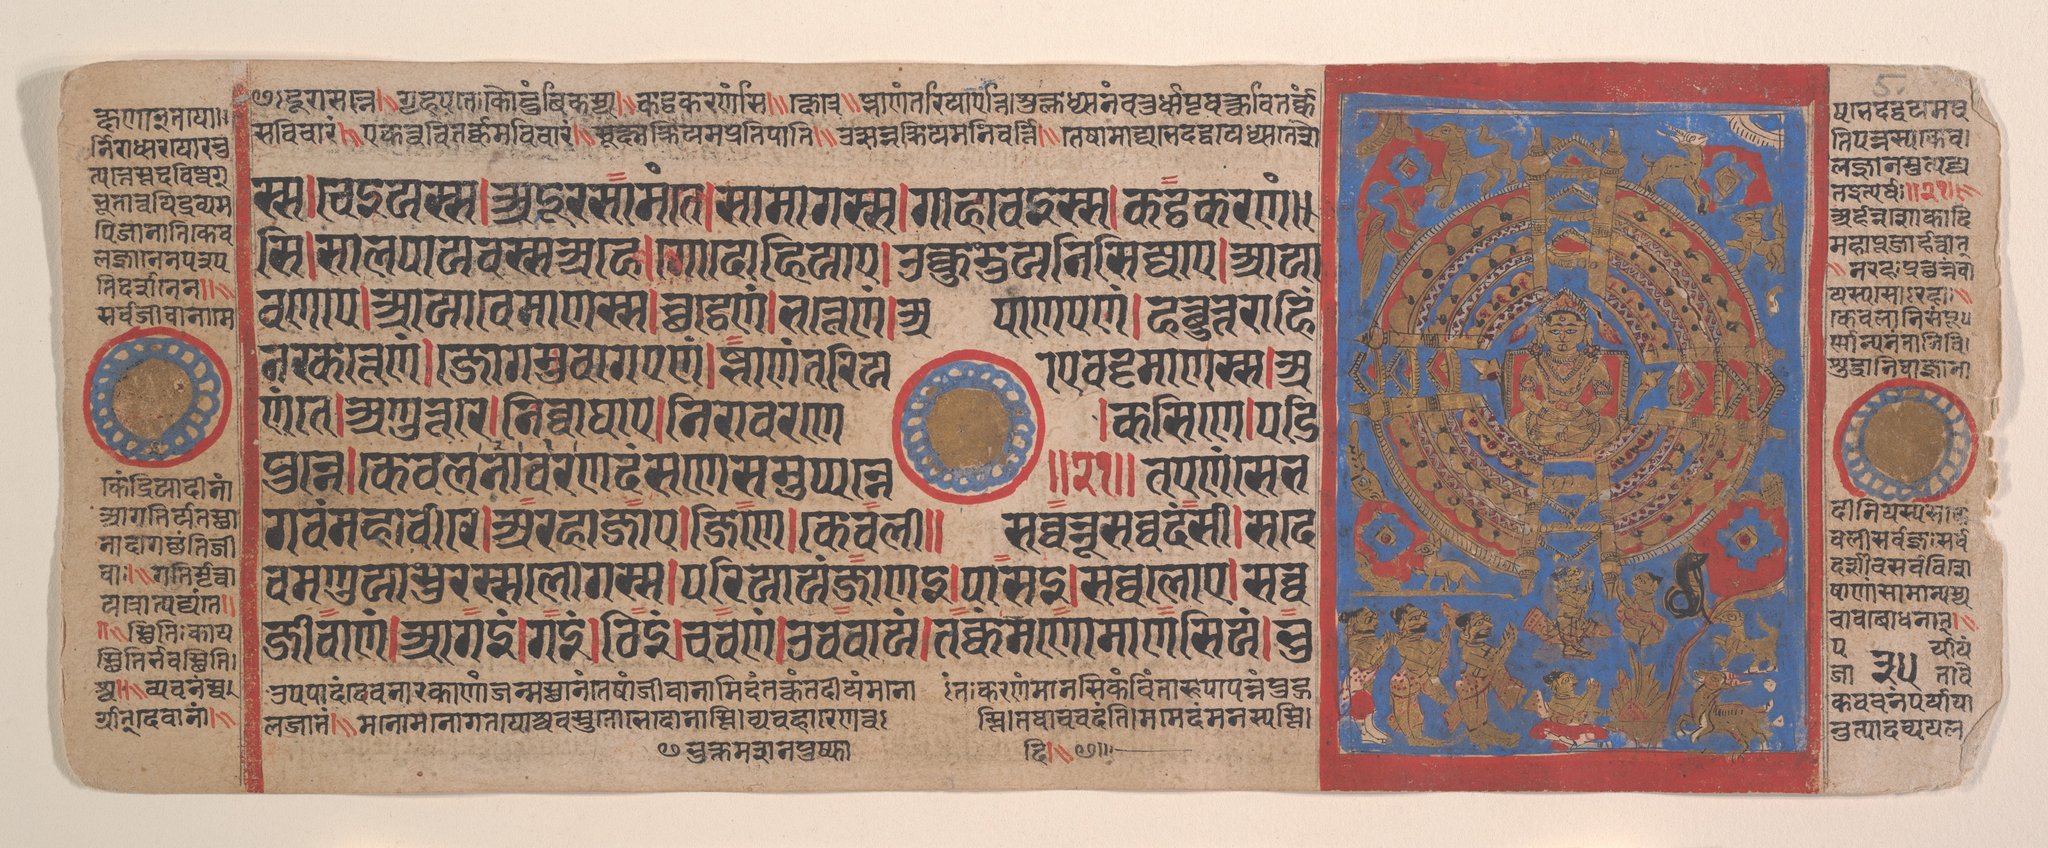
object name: folio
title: Leaf from a Kalpa Sutra (Jain Book of Rituals)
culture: indian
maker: bhadrabahu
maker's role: artist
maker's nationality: indian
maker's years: 356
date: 1401-1500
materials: gold, ink, paper, watercolor